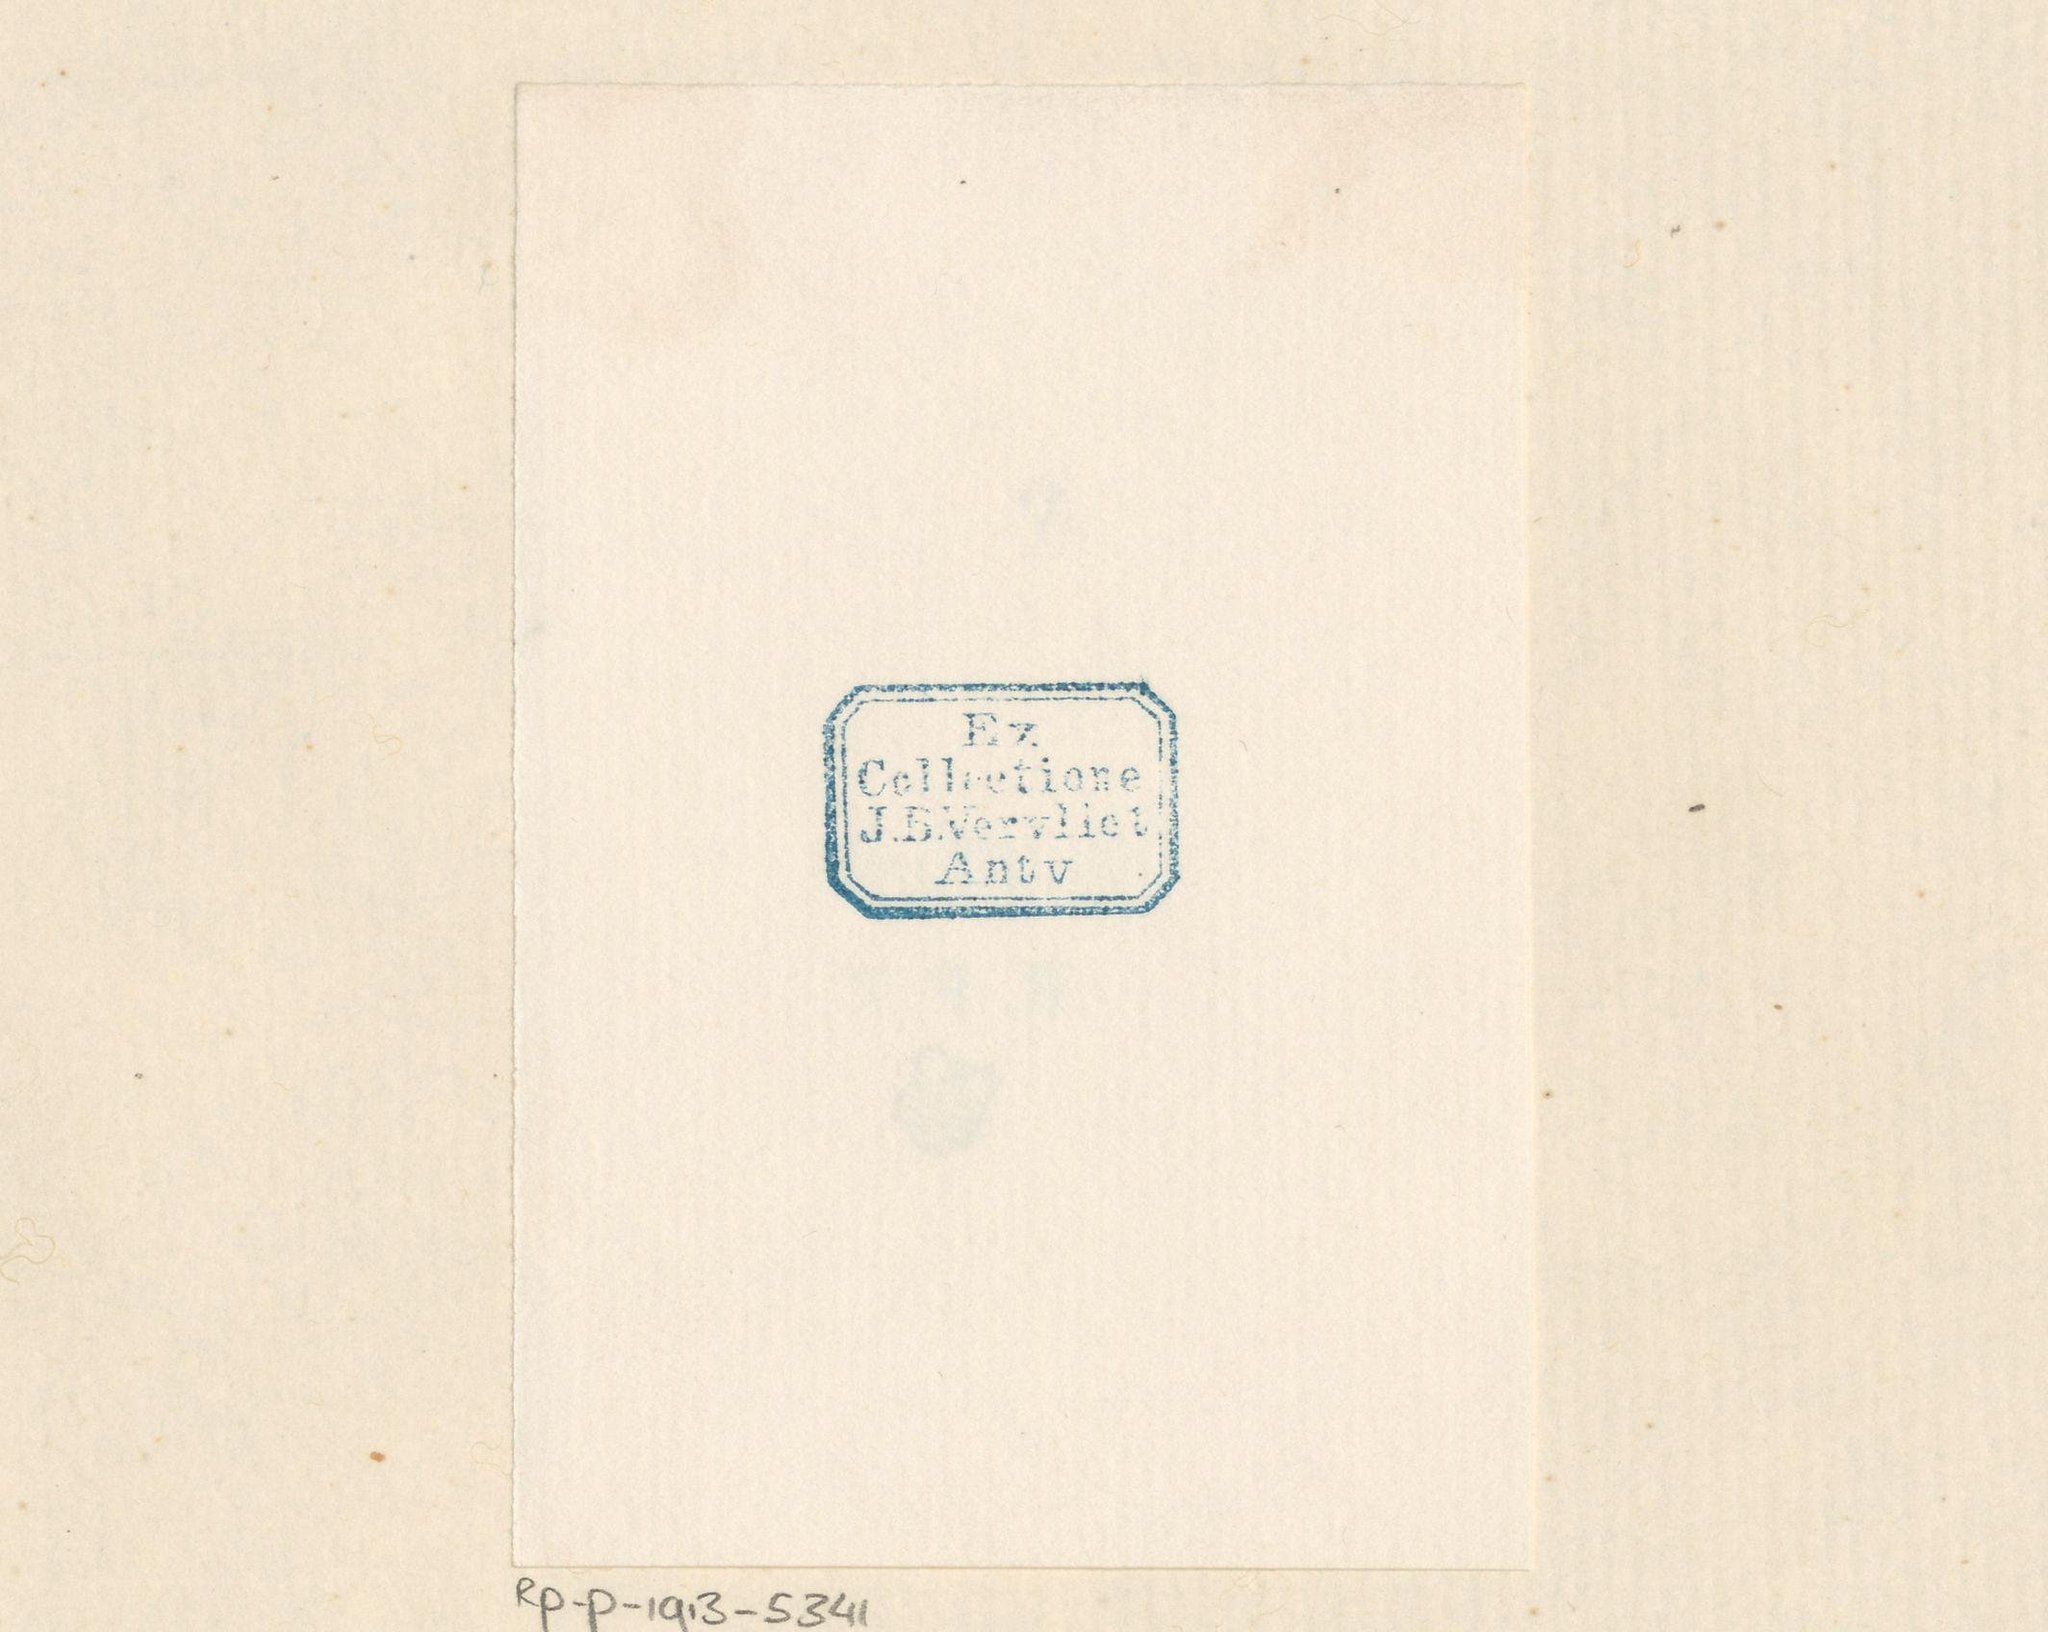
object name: bookplate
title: Ex libris van J.B. Vervliet, Antv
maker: Anonymous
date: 1875-1899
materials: paper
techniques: printing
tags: jan baptist vervliet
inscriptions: collector's mark: Lugt 2760, collector's mark: Lugt 2233